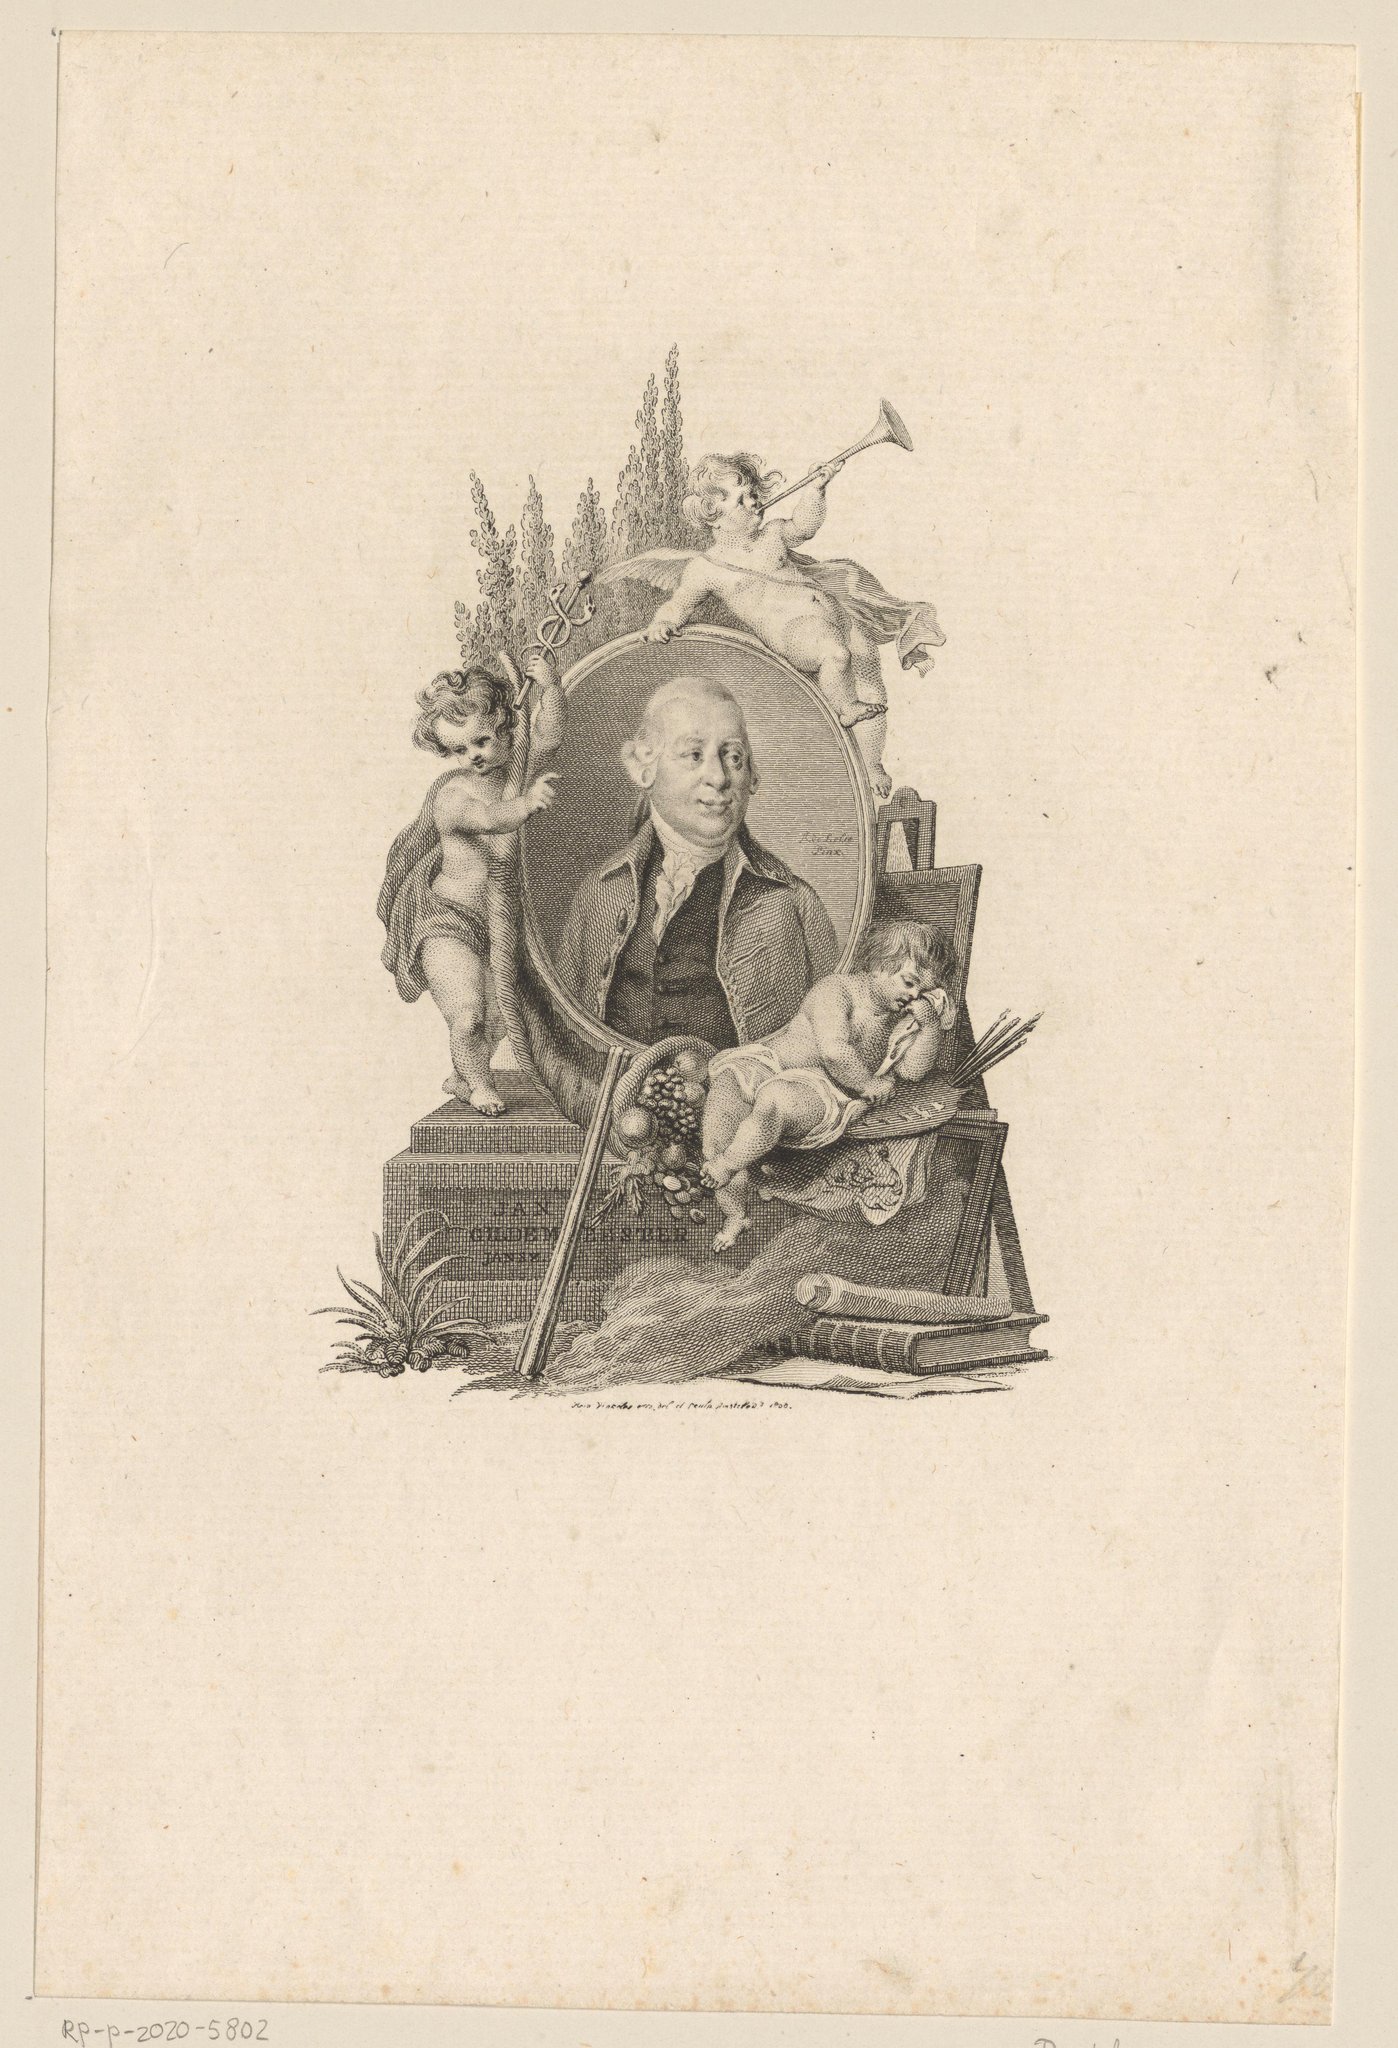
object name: print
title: Portret van Jan Gildemeester Jansz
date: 1800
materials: paper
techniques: engraving, etching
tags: amsterdam, historical persons, art collector, cupids: 'amores', 'amoretti', 'putti'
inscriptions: date